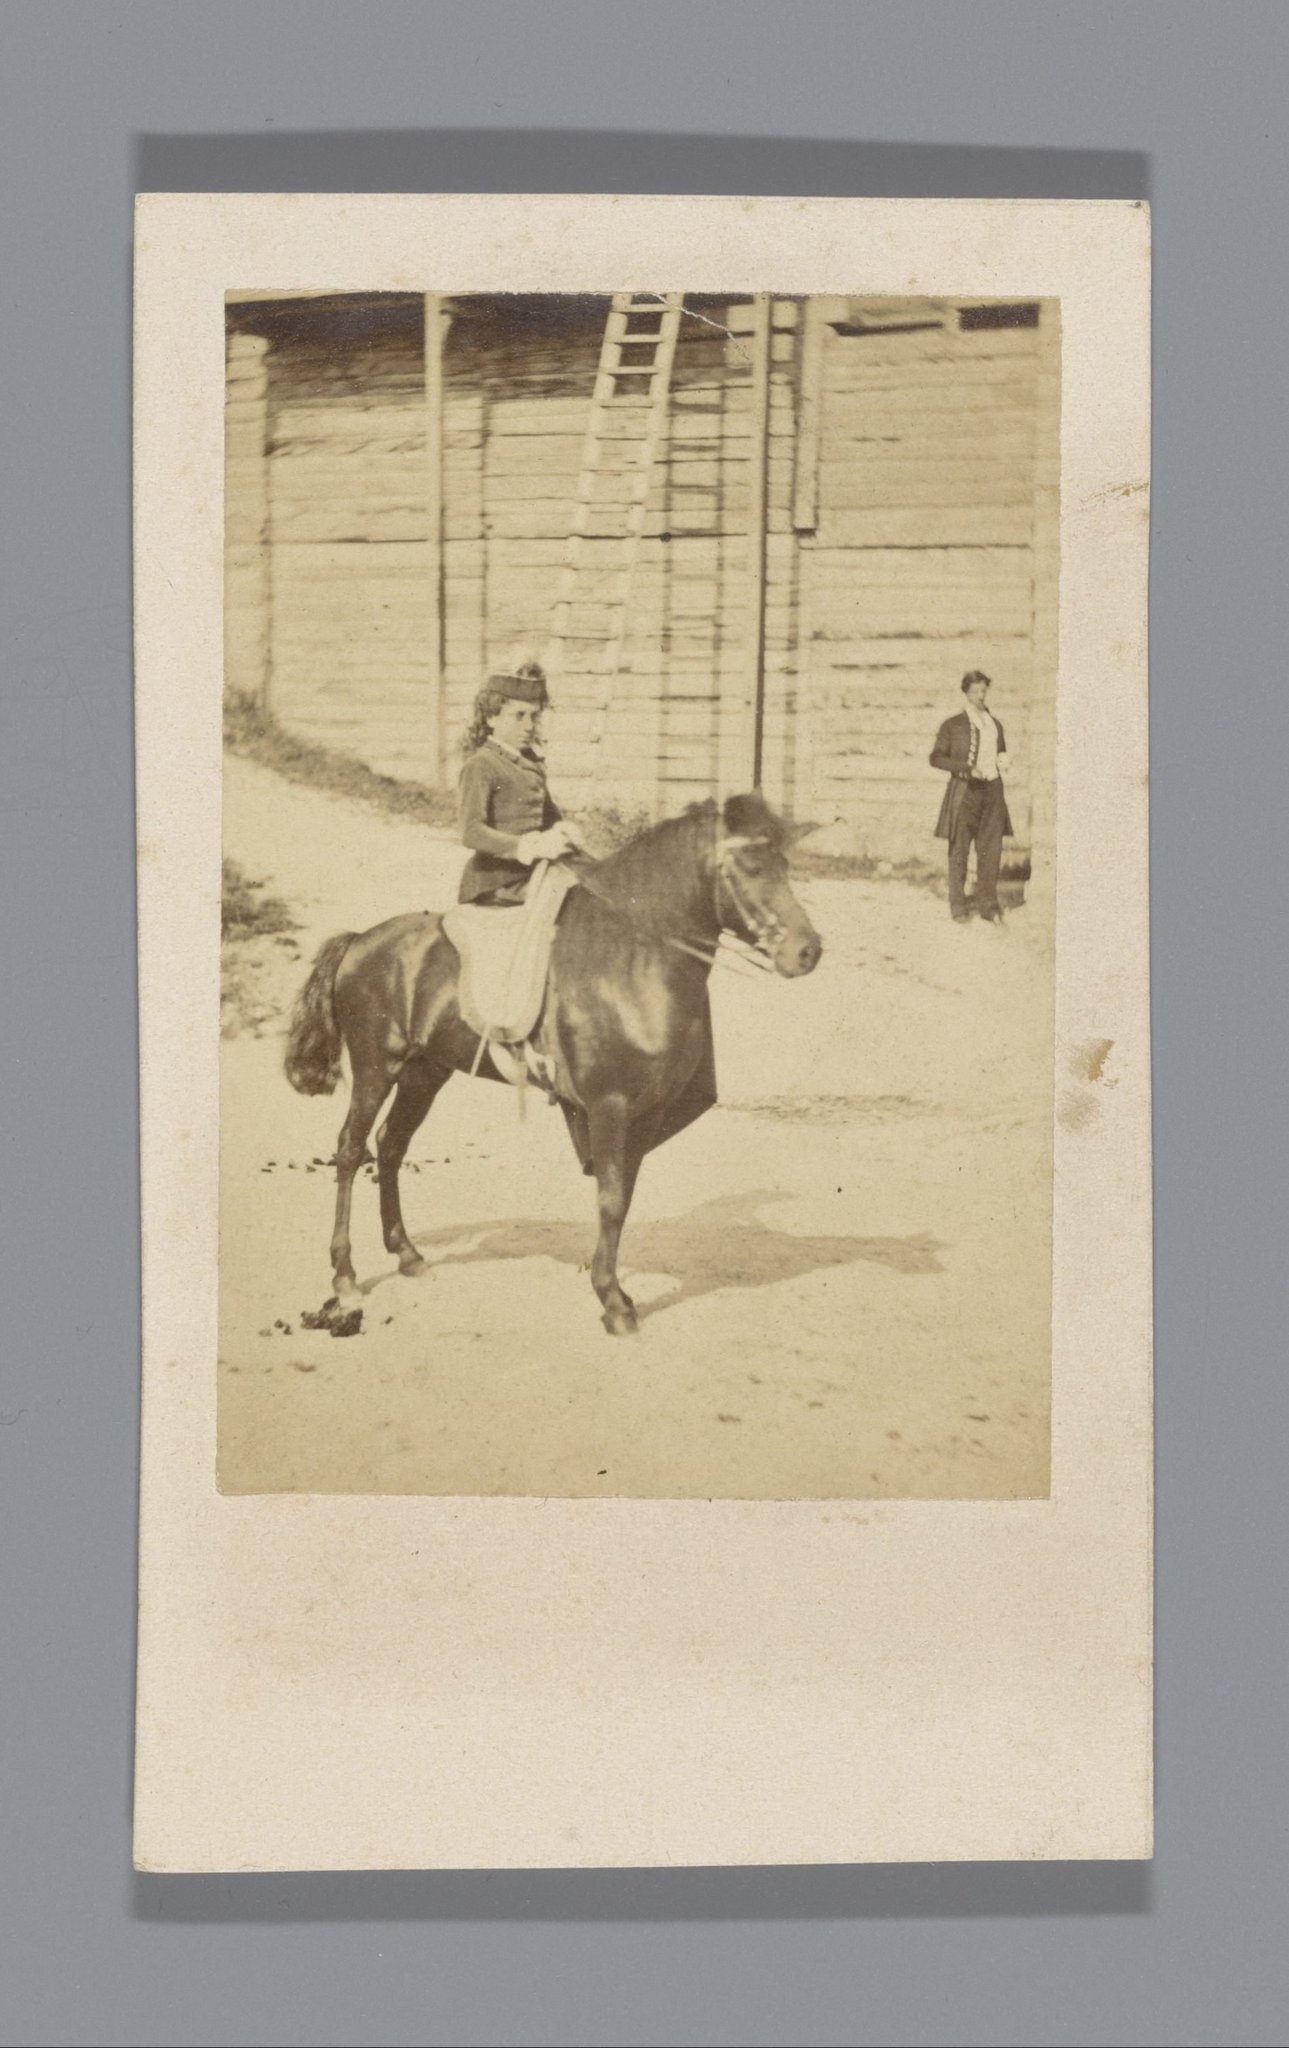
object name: photograph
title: Vrouw te paard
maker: Anonymous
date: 1865-1870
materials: cardboard, paper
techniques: albumen print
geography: france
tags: riding a horse, ass, or mule; rider, horseman, france